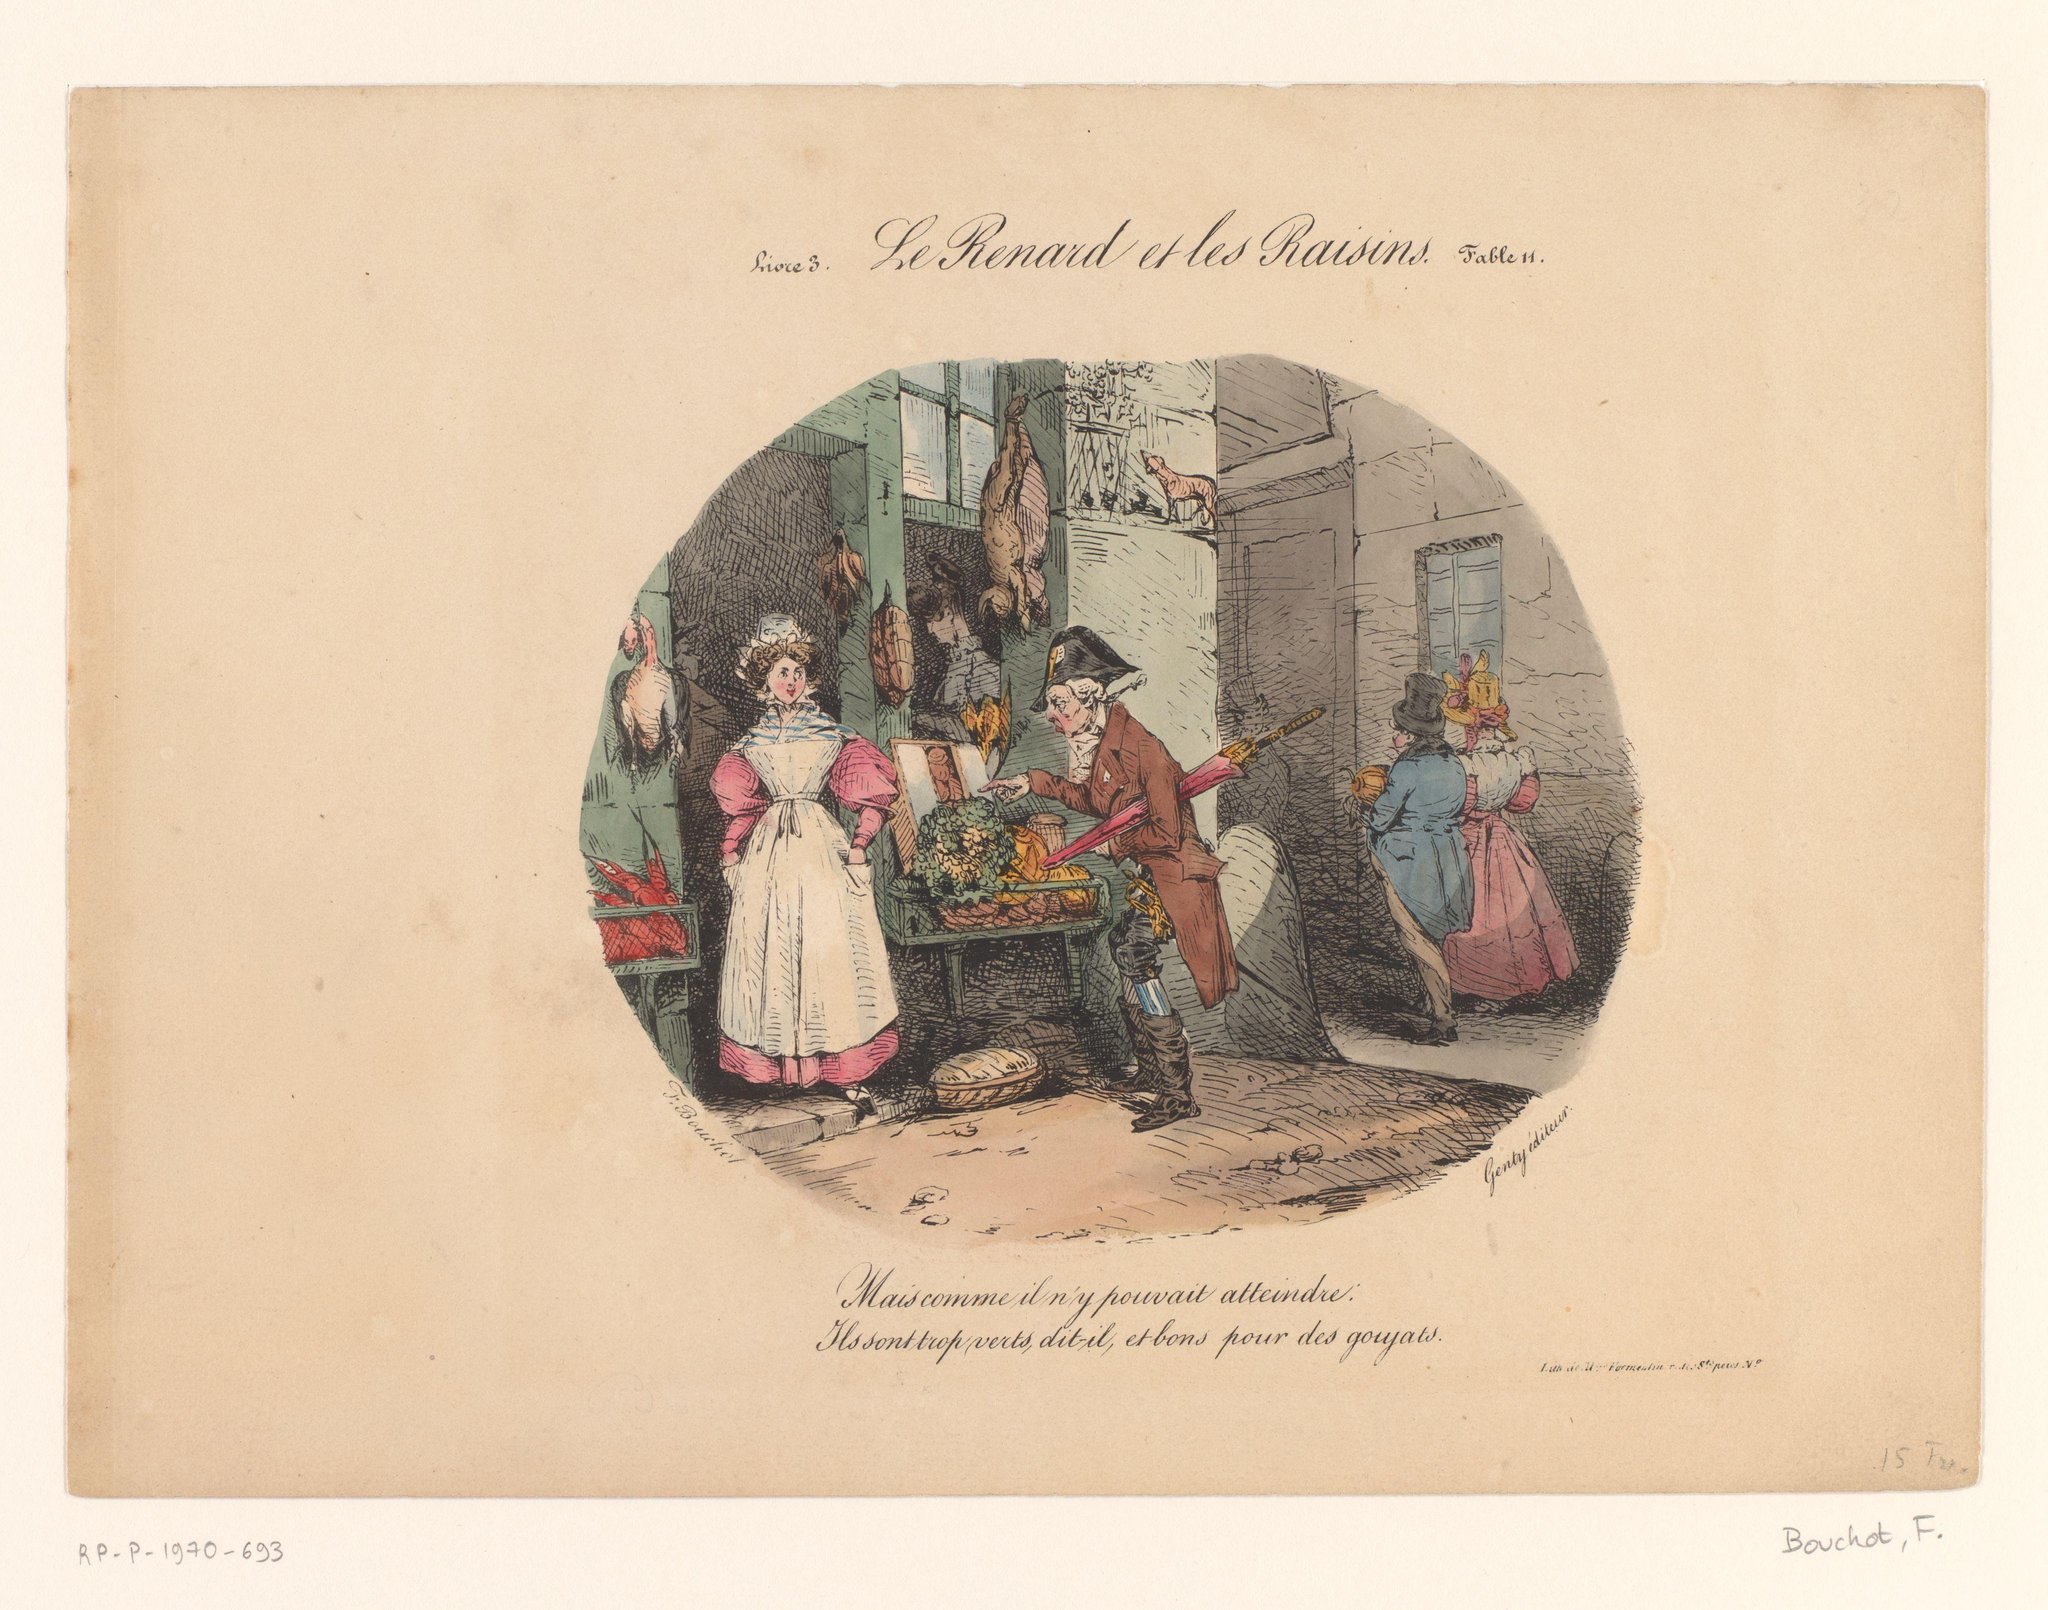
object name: cartoon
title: Le renard et les raisins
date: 1828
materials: paper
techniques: hand coloring, lithograph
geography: paris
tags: fables of aesop : use 85(...), relations between the sexes, bunch of grapes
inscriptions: collector's mark: Lugt 2228a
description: De oude man (de 'vos') kan de druiven niet krijgen, en zegt daarom dat ze nog te groen (te zuur) zijn. In de deuropening van de groentewinkel staat een jonge vrouw.